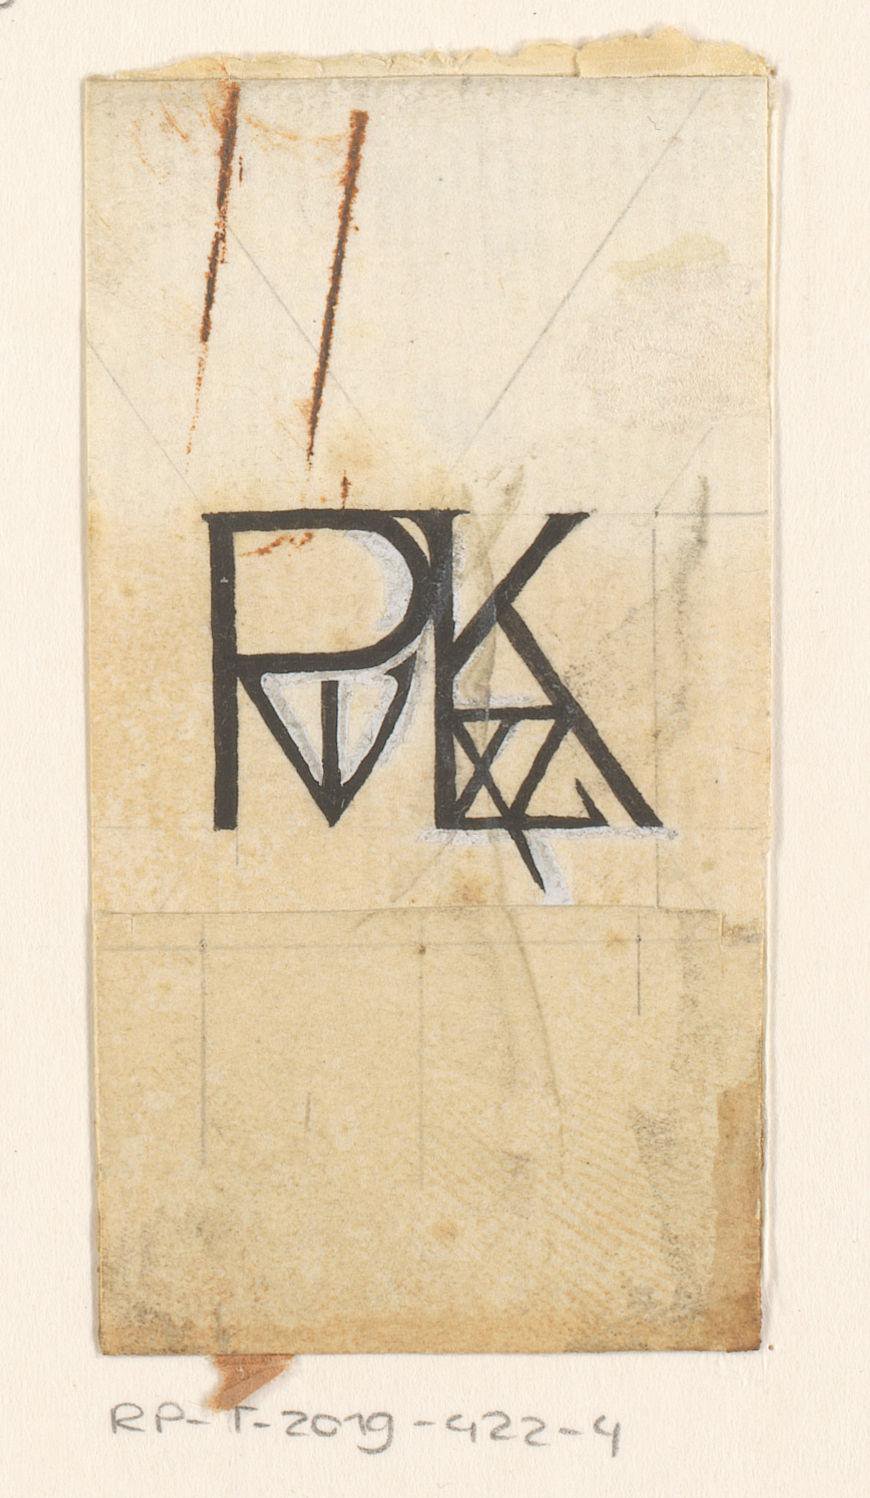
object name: boekrug ontwerp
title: Vignet van uitgeverij P.N. van Kampen en Zoon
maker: richard nicolaüs roland holst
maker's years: 1868-1938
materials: paint, ink, paper, pencil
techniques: pen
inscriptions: :, collector's mark: Lugt 2228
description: Bandontwerp voor: Huygens, Cornélie. Barthold Meryan. Amsterdam: Van Kampen, 1899.